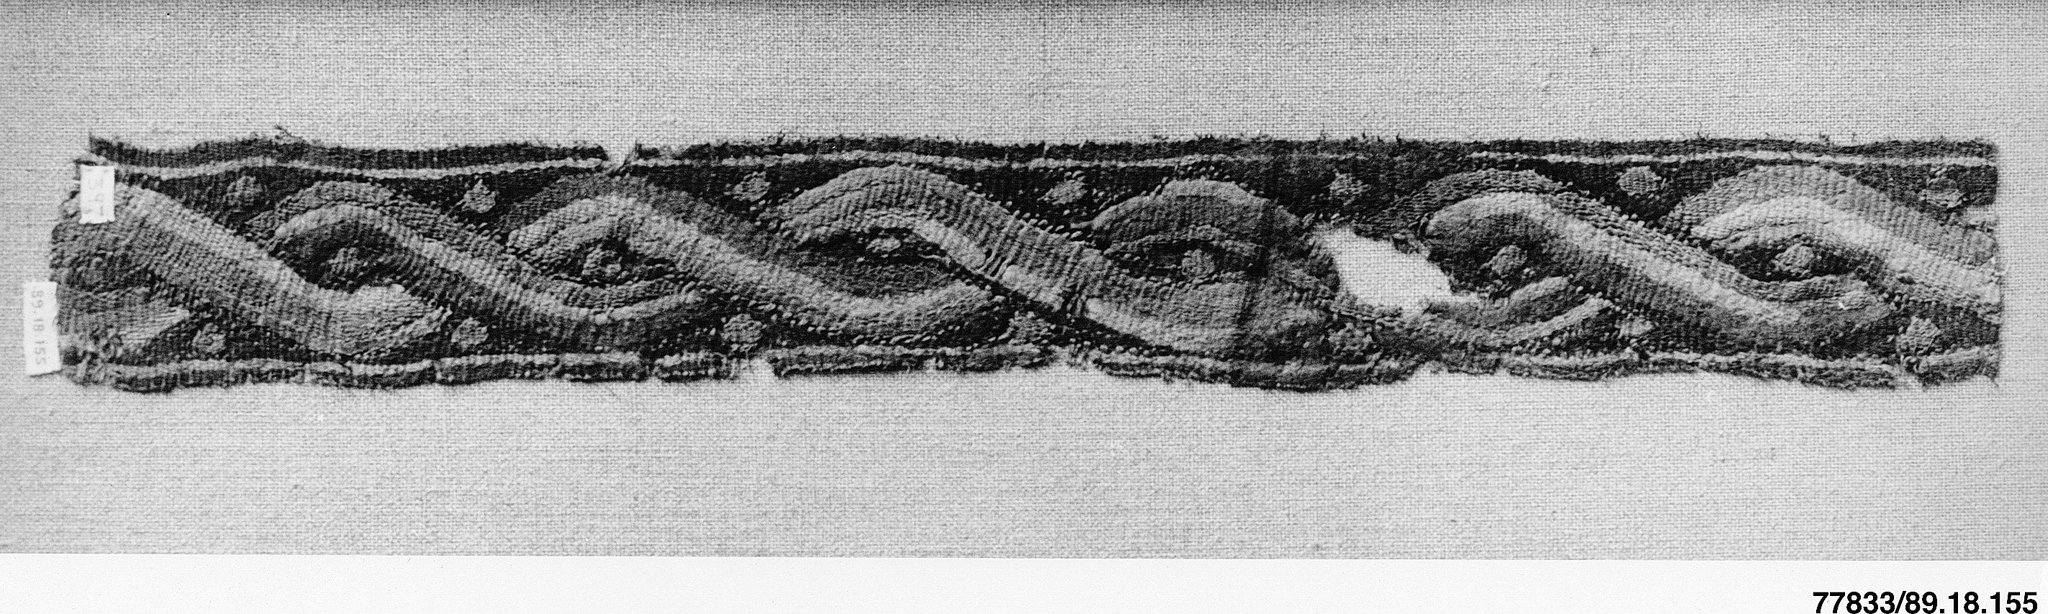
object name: textile fragment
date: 301-500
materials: linen, wool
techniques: weave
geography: egypt